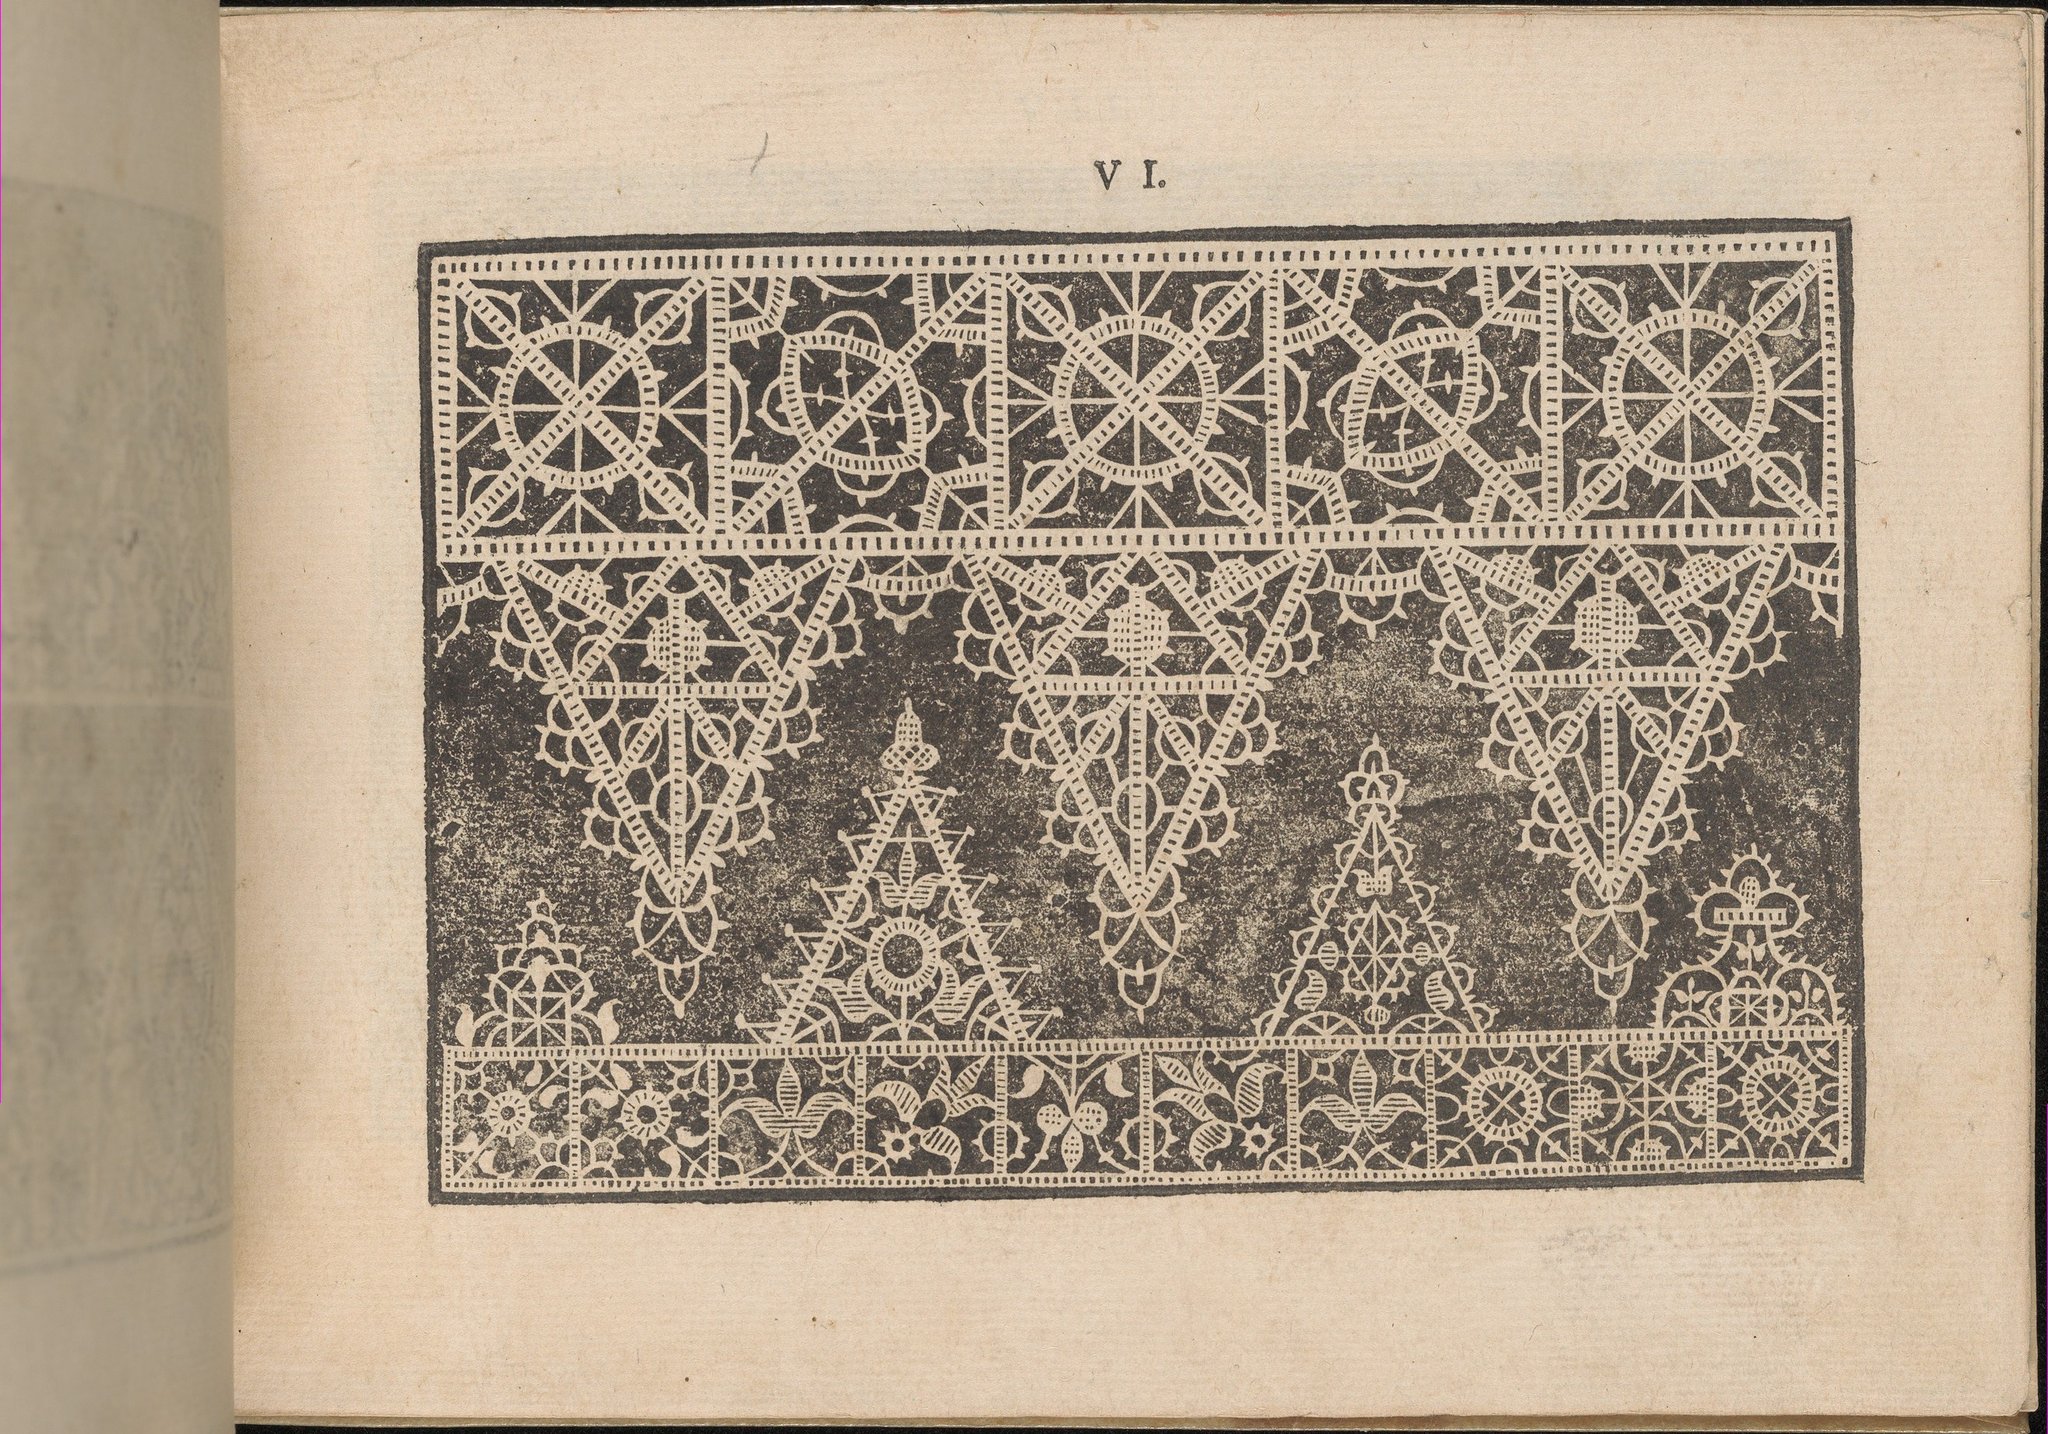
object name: book print ornament architecture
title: Prima Parte de' Fiori, e Disegni di varie sorti di Ricami Moderni, page 6 (recto)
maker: giovanni battista ciotti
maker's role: author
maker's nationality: italian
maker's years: 1555-1659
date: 1591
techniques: woodcut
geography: italy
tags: ornament